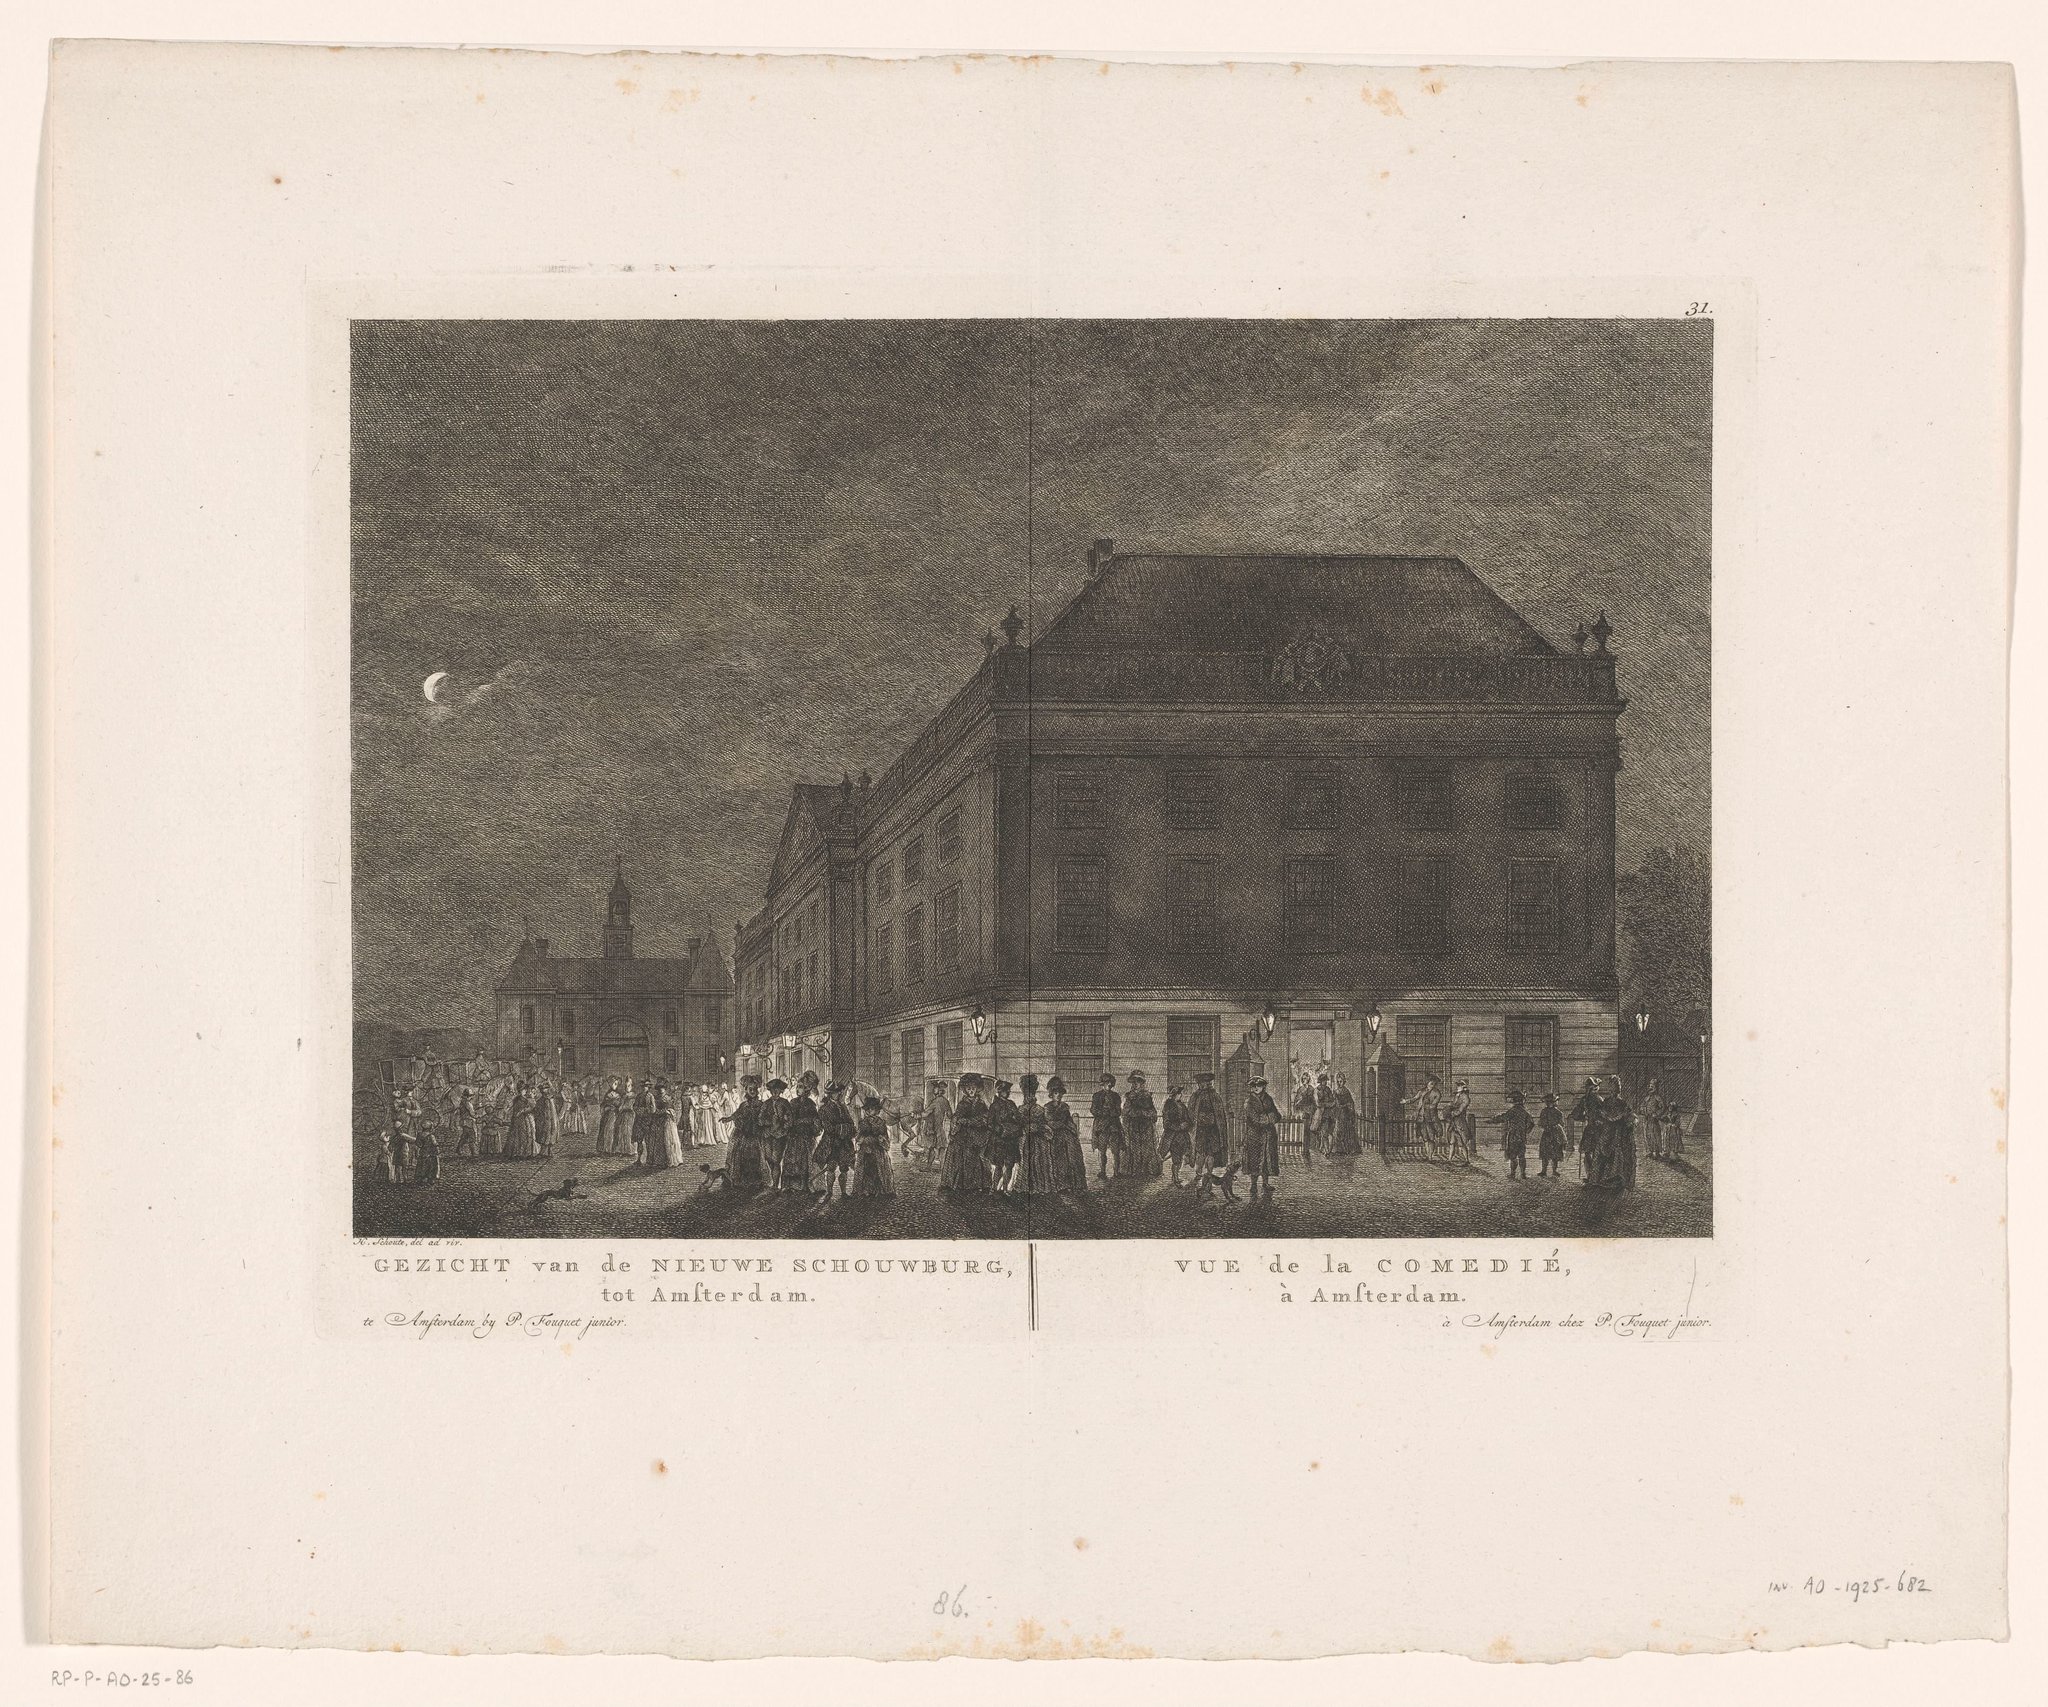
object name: print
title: Gezicht op de schouwburg aan het Leidseplein te Amsterdam bij avond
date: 1774-1783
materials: paper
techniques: engraving, etching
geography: amsterdam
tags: theatre (building), city-gate, square, place, circus, etc. (+ city(-scape) with figures, staffage)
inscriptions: collector's mark: Lugt 2228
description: Deze prent is ook gebruikt in de zogenaamde Atlas van Fouquet.* Pierre Fouquet gaf vanaf 1760 stadsgezichten van Amsterdam - naar tekeningen van verschillende kunstenaars, gemaakt door verschillende prentmakers - uit. Deze prenten werden aanvankelijk los of in series verkocht. Zoals toen gebruikelijk kon de koper de prenten zelf laten inbinden. Hiertoe gaf Fouquet tussen 1778 en 1783 een titelblad, plattegrond en inhoudsopgave van de tot dusver 100 uitgegeven prenten uit (1). Gezien de inhoud afhankelijk was van wat de koper had verzameld verschilt de inhoud van de verschillende bewaarde Fouquetatlassen onder deze titel sterk. Ook zijn er exemplaren bekend waar tevens andere prenten aan zijn toegevoegd. Omdat er behoefte bleek aan uitleg bij de platen werd in 1783 een nieuwe versie van de atlas uitgegeven, aangevuld met tekst en twee prenten. De aangegeven volgorde veranderde maar de platen van de al eerder uitgegeven prenten bleven ongewijzigd. Deze uitgave werd in opdracht van Fouquet gedrukt bij Daniël Jean Changuion en Petrus den Hengst (2). Een tiental platen werd bijgewerkt en verscheen, met nieuw impressum, in het vervolg van Wagenaars geschiedenis van Amsterdam, uitgeven door Petrus Conradi en Folkert van der Plaats (3). Een aantal jaar na het overlijden van Fouquet kwam Evert Maaskamp met een nieuwe uitgave van de atlas, met verbeterde tekst en toevoeging van twee prenten. Op alle platen verwijderde hij het oude en liet hij zijn eigen impressum zetten (4). De huidige staat van de prent komt voor in exemplaren van de onder (1) en (2) genoemde werken. * Onder de Atlas van Fouquet of Fouquetatlas verstaan we de hieronder vermelde publicaties (1), (2) en (4). (1). Afbeeldingen van de wyd-vermaarde koopstad Amsterdam benevens des zelvs voornaamste gebouwen en gezigten alle naar het leeven getekend / Receuil des edifices les plus considerables et des plus belles vues, de la fameuse ville d'Amsterdam, dessinées d'après nature. Amsterdam: Pierre Fouquet, 1778-1783. (2). Nieuwe atlas, van de voornaamste gebouwen en gezigten der stad Amsterdam, met derzelver beknopte beschryvingen. 2 delen. Amsterdam: Daniël Jean Changuion en Petrus den Hengst [in opdracht van Pierre Fouquet], 1783. (3). Stijl, Simon. Amsterdam, in zyne geschiedenissen, voorregten, koophandel, gebouwen, kerkenstaat, schoolen, schutterye, gilden en regeeringe, beschreeven. Om te dienen ten vervolge op het werk van Jan Wagenaar (…). 10 delen. Amsterdam en Harlingen: Petrus Conradi en Folkert van der Plaats, 1788-1801. (4). Nieuwe atlas, van de voornaamste gebouwen en gezigten der stad Amsterdam. Met derzelver beknopte beschryvingen. Amsterdam: Evert Maaskamp, 1805. * Het aantal vermelde staten is gebaseerd op het aantal gevonden staten. Mogelijk zijn er meer staten van deze prent.